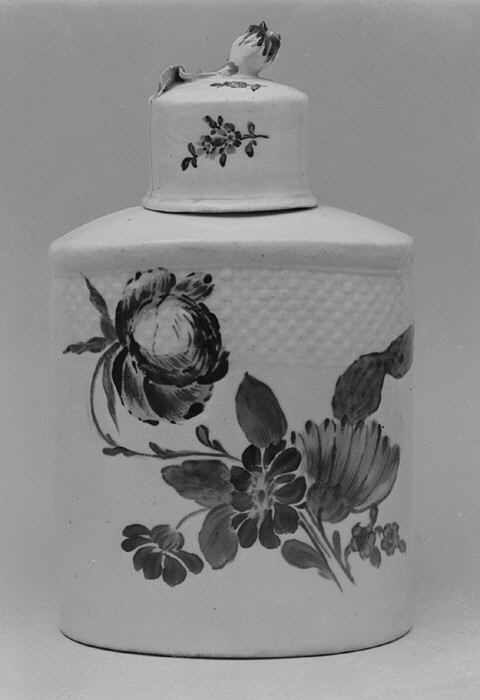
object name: caddy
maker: limbach porcelain manufactory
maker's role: manufactory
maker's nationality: german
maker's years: 1762-1939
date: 1775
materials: hard paste porcelain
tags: flowers